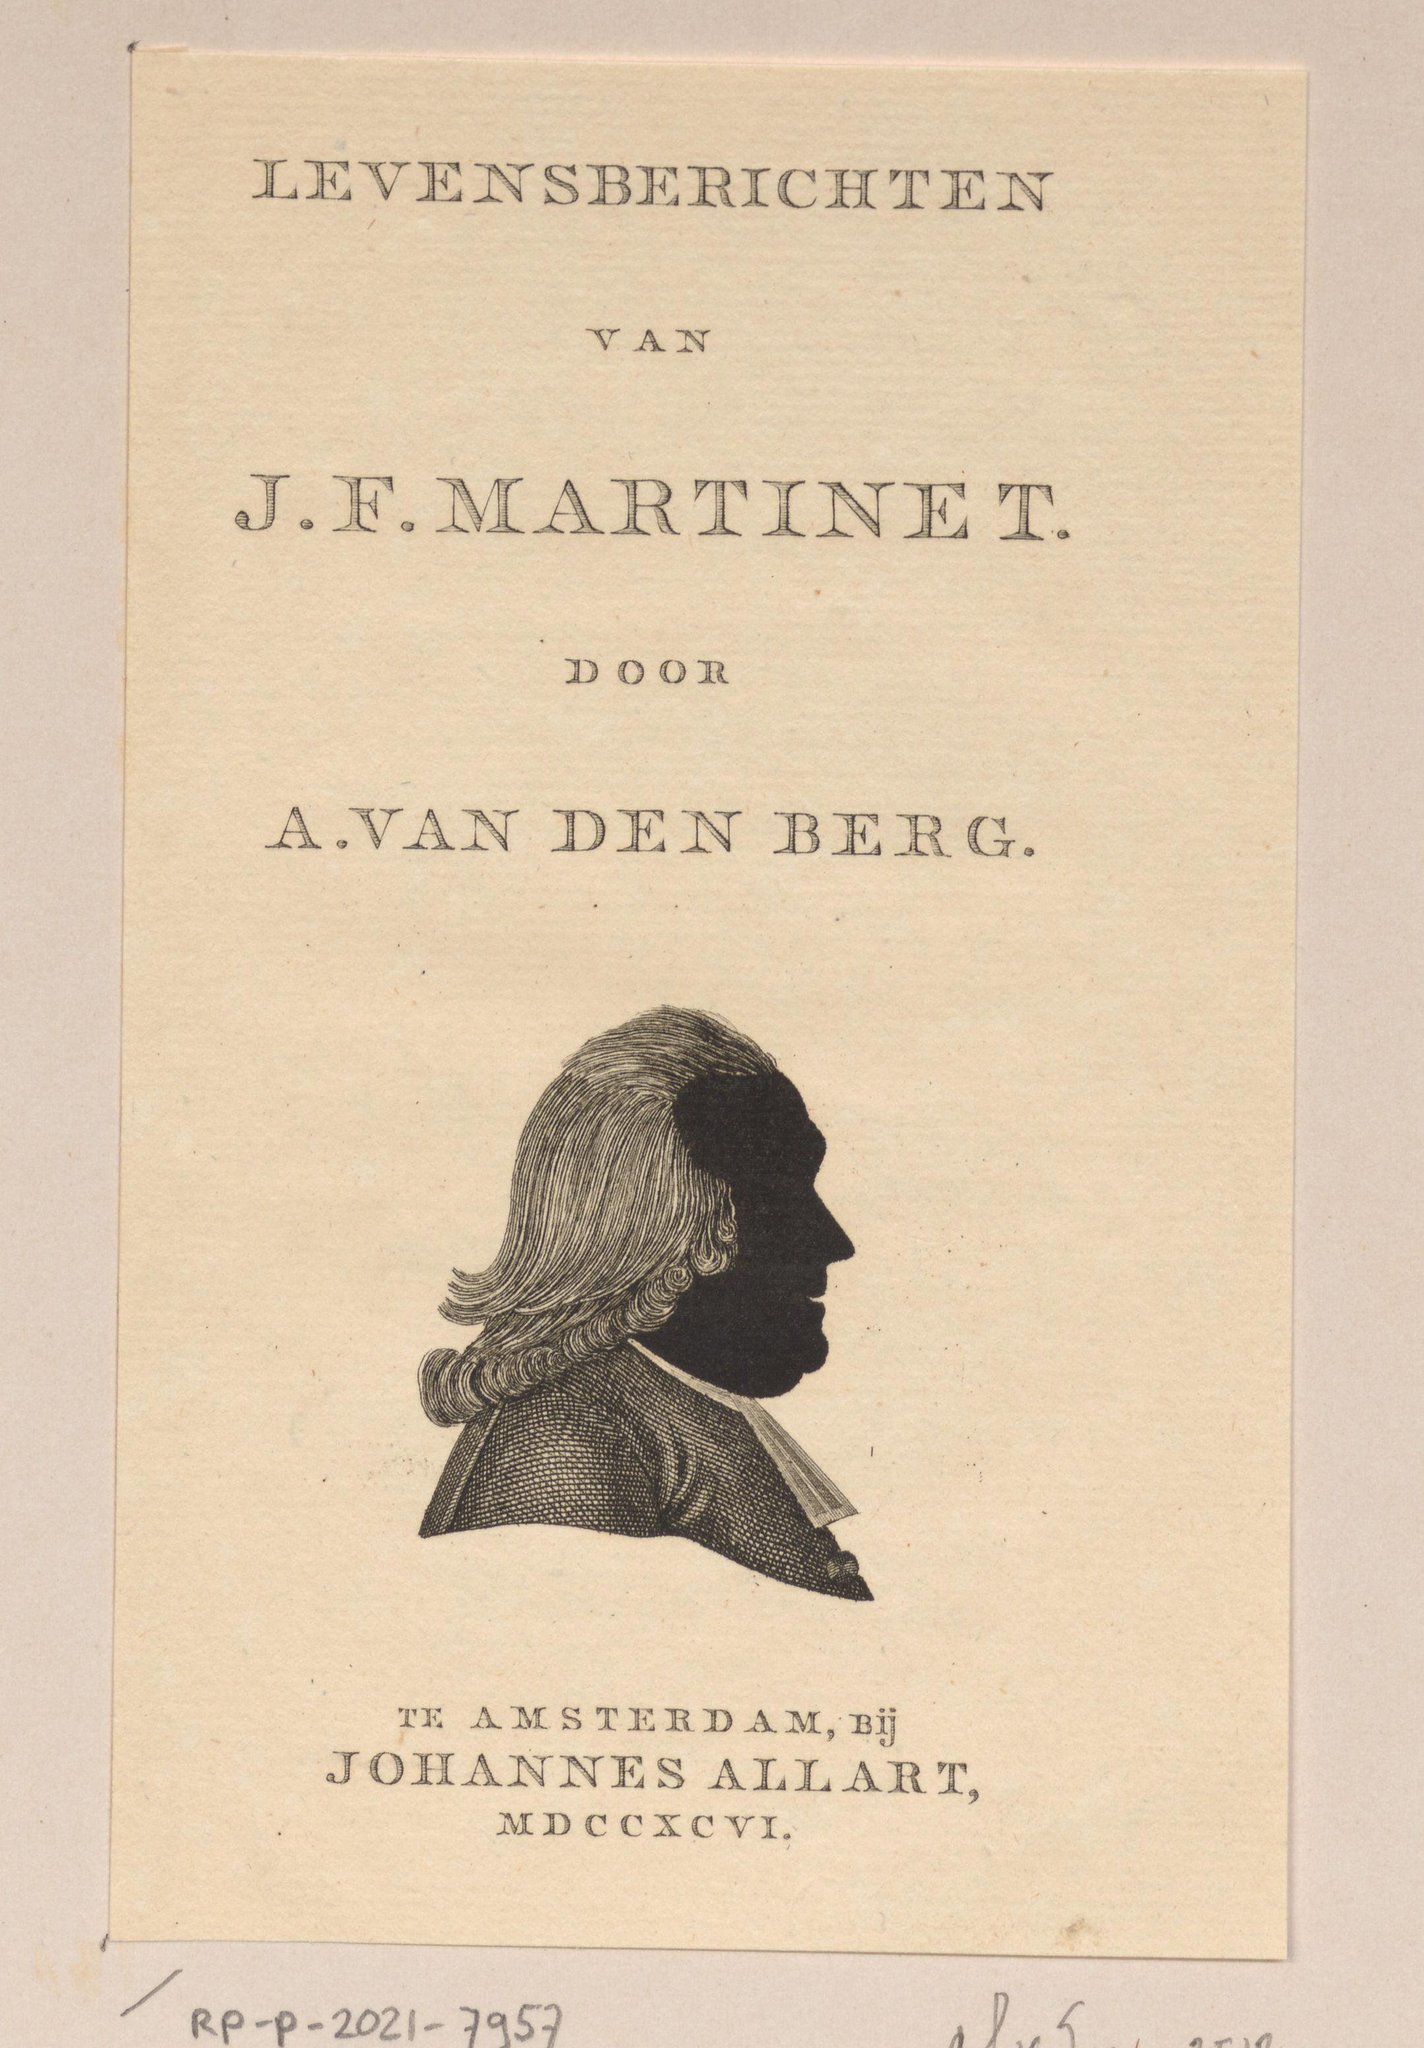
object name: titelblad, titelpagina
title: Silhouetportret van Joannes Florentius Martinet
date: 1796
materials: paper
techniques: etching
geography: amsterdam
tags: joannes florentius martinet, historical persons, portrait of a writer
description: Titelpagina voor: Martinet, Joannes Florentius. Levensberichten van J.F. Martinet. Amsterdam: Johannes Allart, 1796.